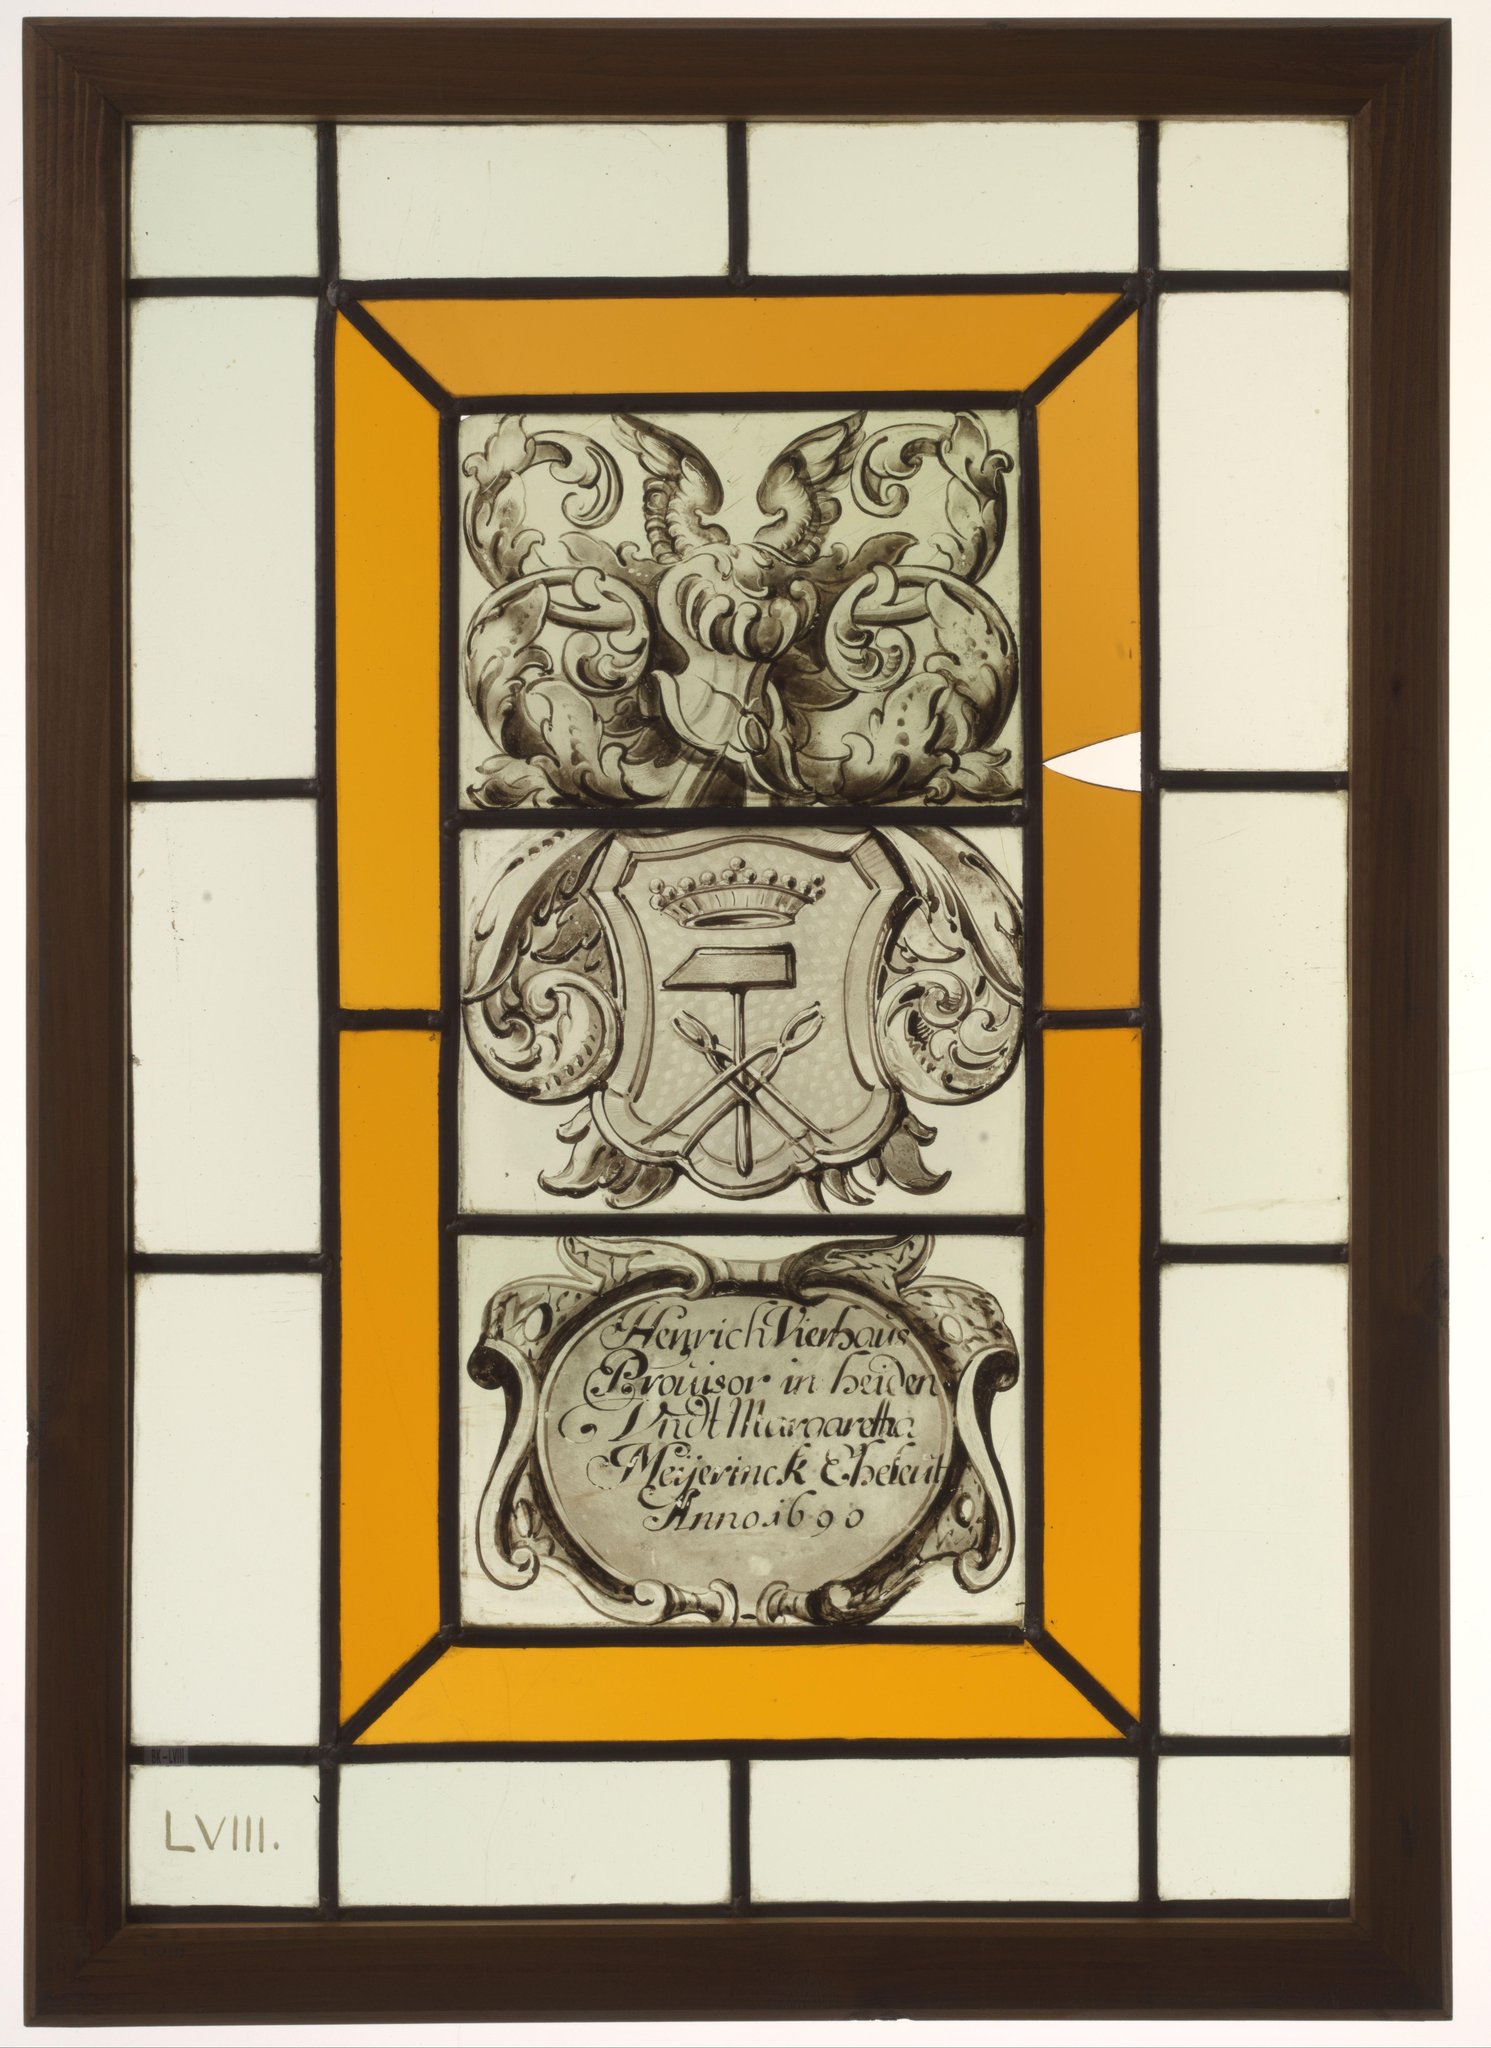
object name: wapenruit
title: Ruit met wapen met smidsattributen met onderschrift "Heinrich Vierhaus Provisor in Leiden und Margaretha Meyernick Eheleuthe Ao 1690"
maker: Anonymous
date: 1690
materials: glass, lead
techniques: leading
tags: leiden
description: Ruit met wapen met smidsattributen. Omgeven met ornamenten waaronder een cartouche waarin "Heinrich Vierhaus Provisor in Leiden und Margaretha Meyernick Eheleuthe Ao 1690"